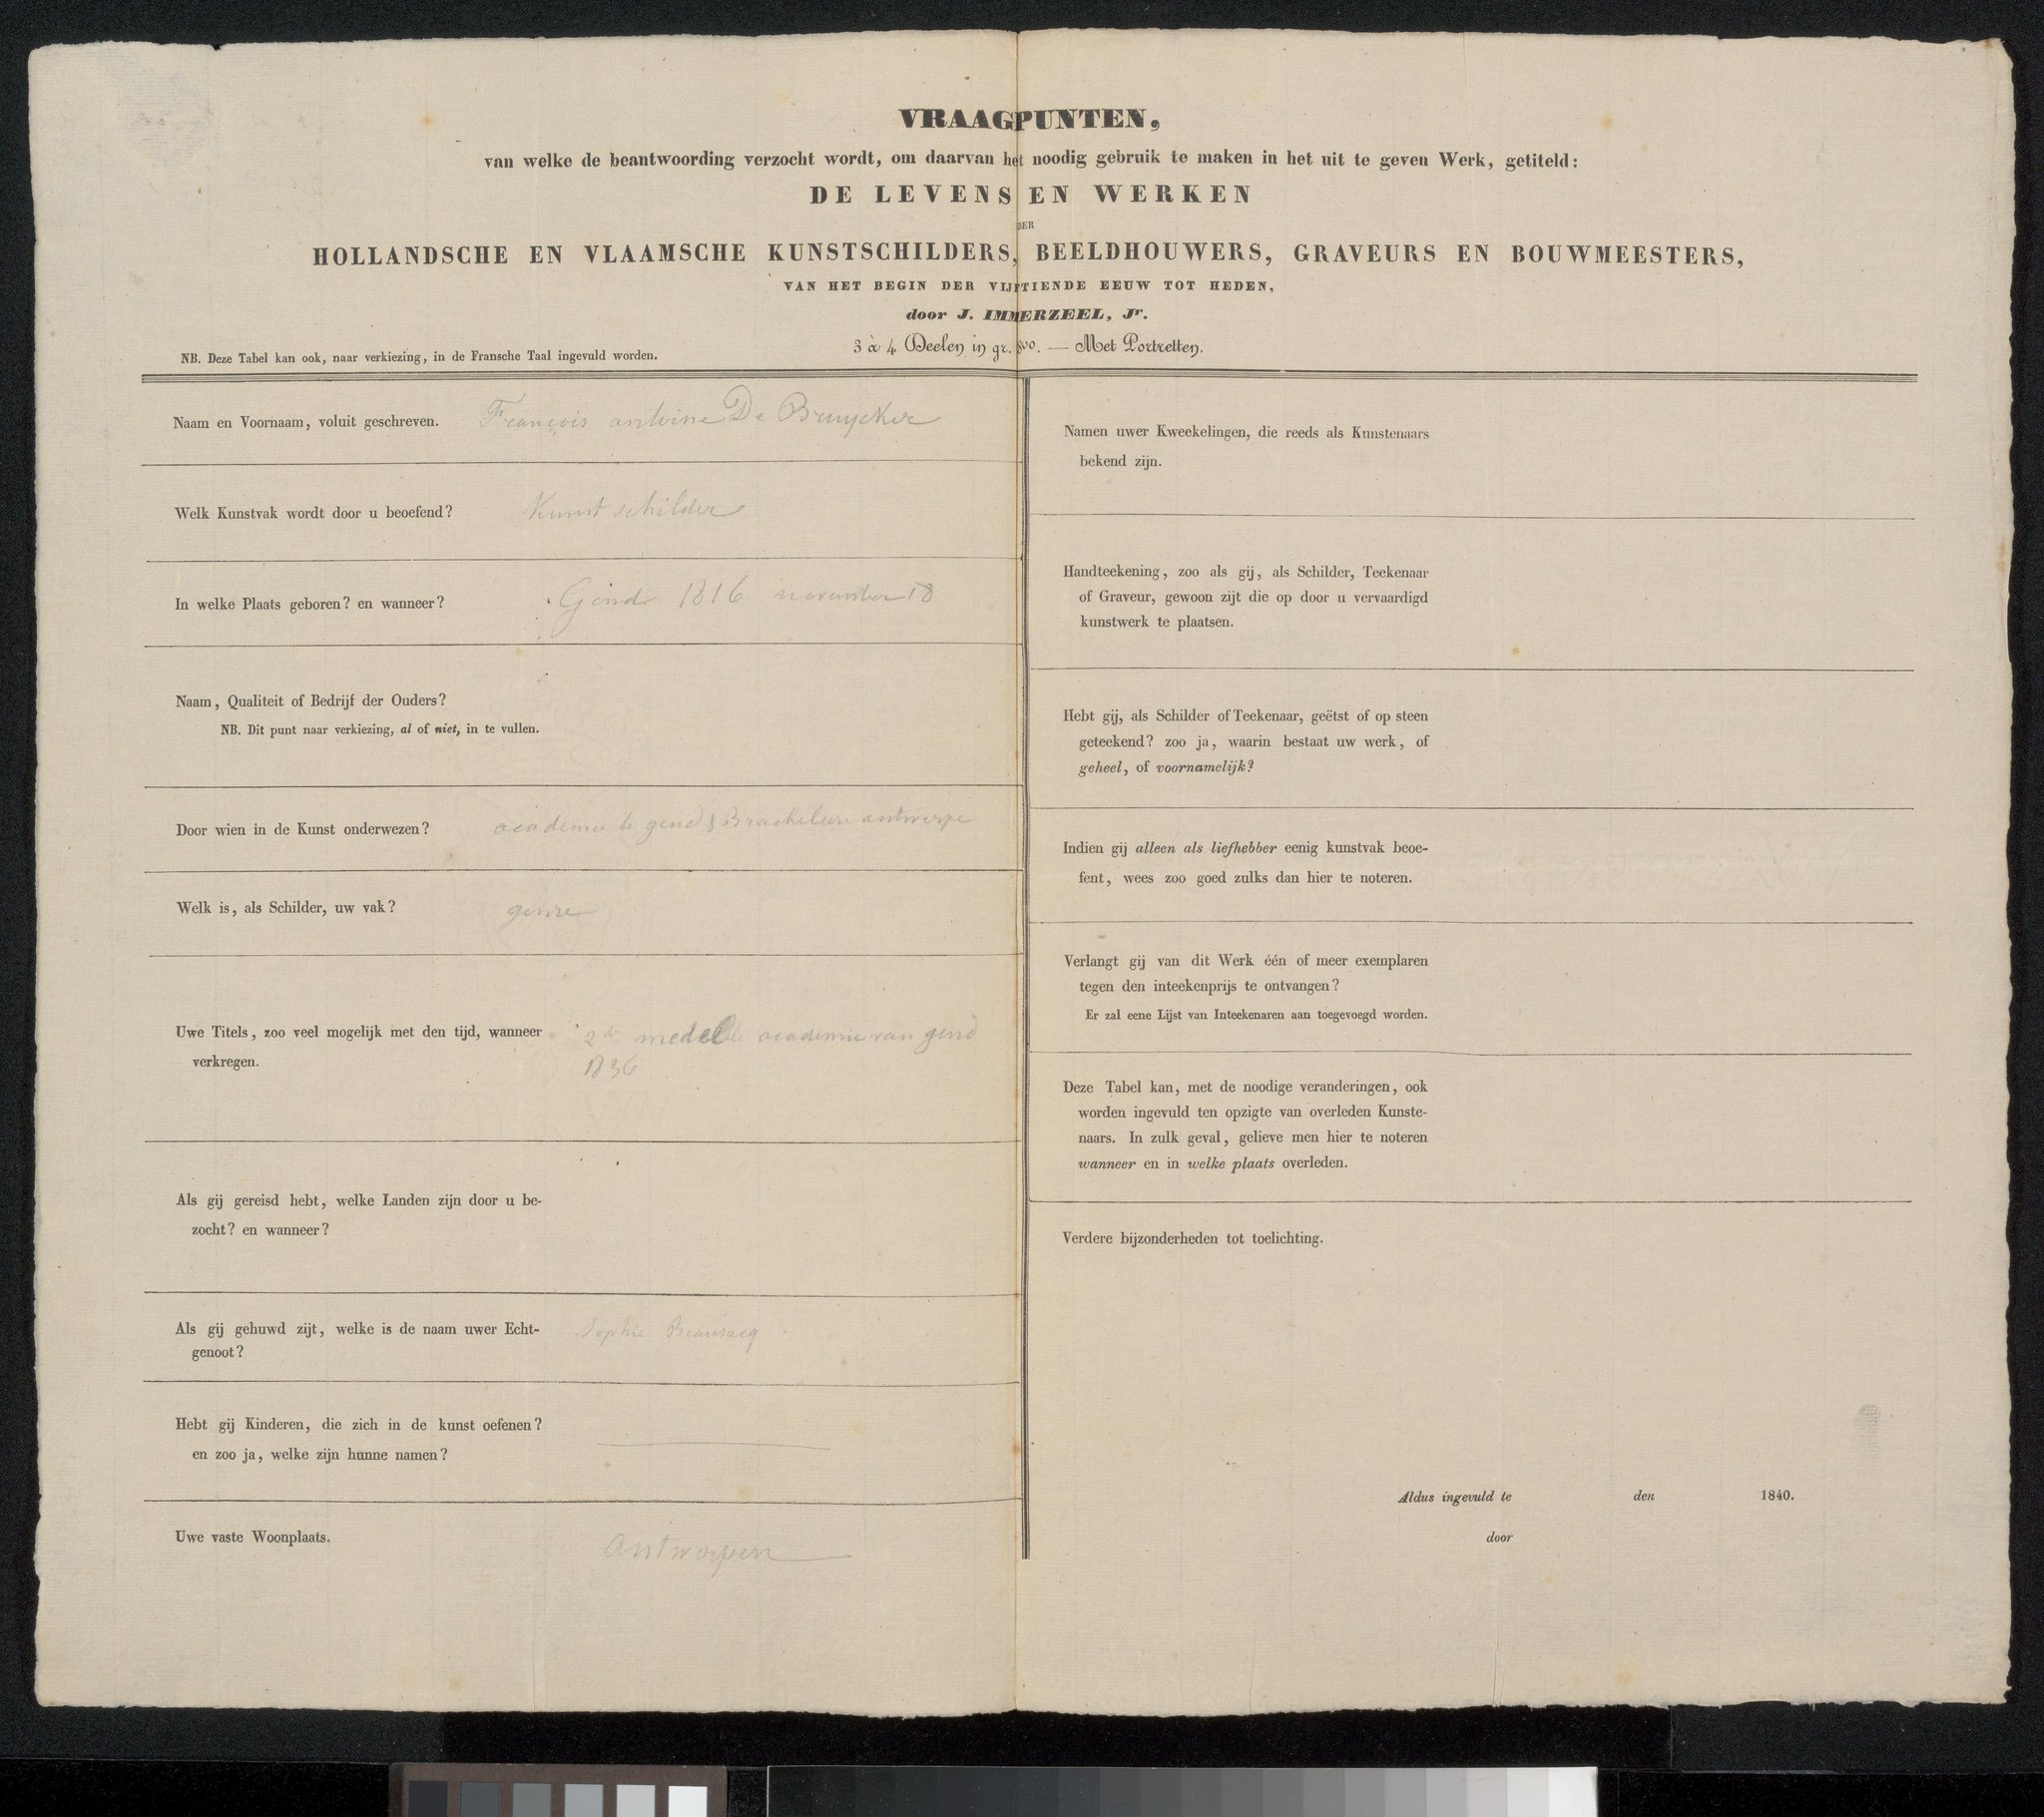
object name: manuscript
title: Enquêteformulier ingevuld door François Antoine De Bruycker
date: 1840-1841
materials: paper, pencil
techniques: printing, writing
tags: ghent, antwerp, painter, françois antoine de bruycker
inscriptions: inscription: ‘Vraagpunten,/ van welke de beantwoording verzocht wordt, om daarvan het noodig gebruik te maken in het uit te geven Werk, getiteld: De levens en werken/ der Hollandsche en Vlaamsche kunstschilders, beeldhouwers,/ graveurs en bouwmeesters, van het begin der vijftiende eeuw tot heden/ door J. Immerzeel, Jr.’, watermark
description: Opgenomen in: Immerzeel, J. Jr., De levens en werken der Hollandsche en Vlaamsche kunstschilders, beeldhouwers, graveurs en bouwmeesters, van het begin der vijftiende eeuw tot heden, Amsterdam: J.C. van Kesteren, 1842-1843.